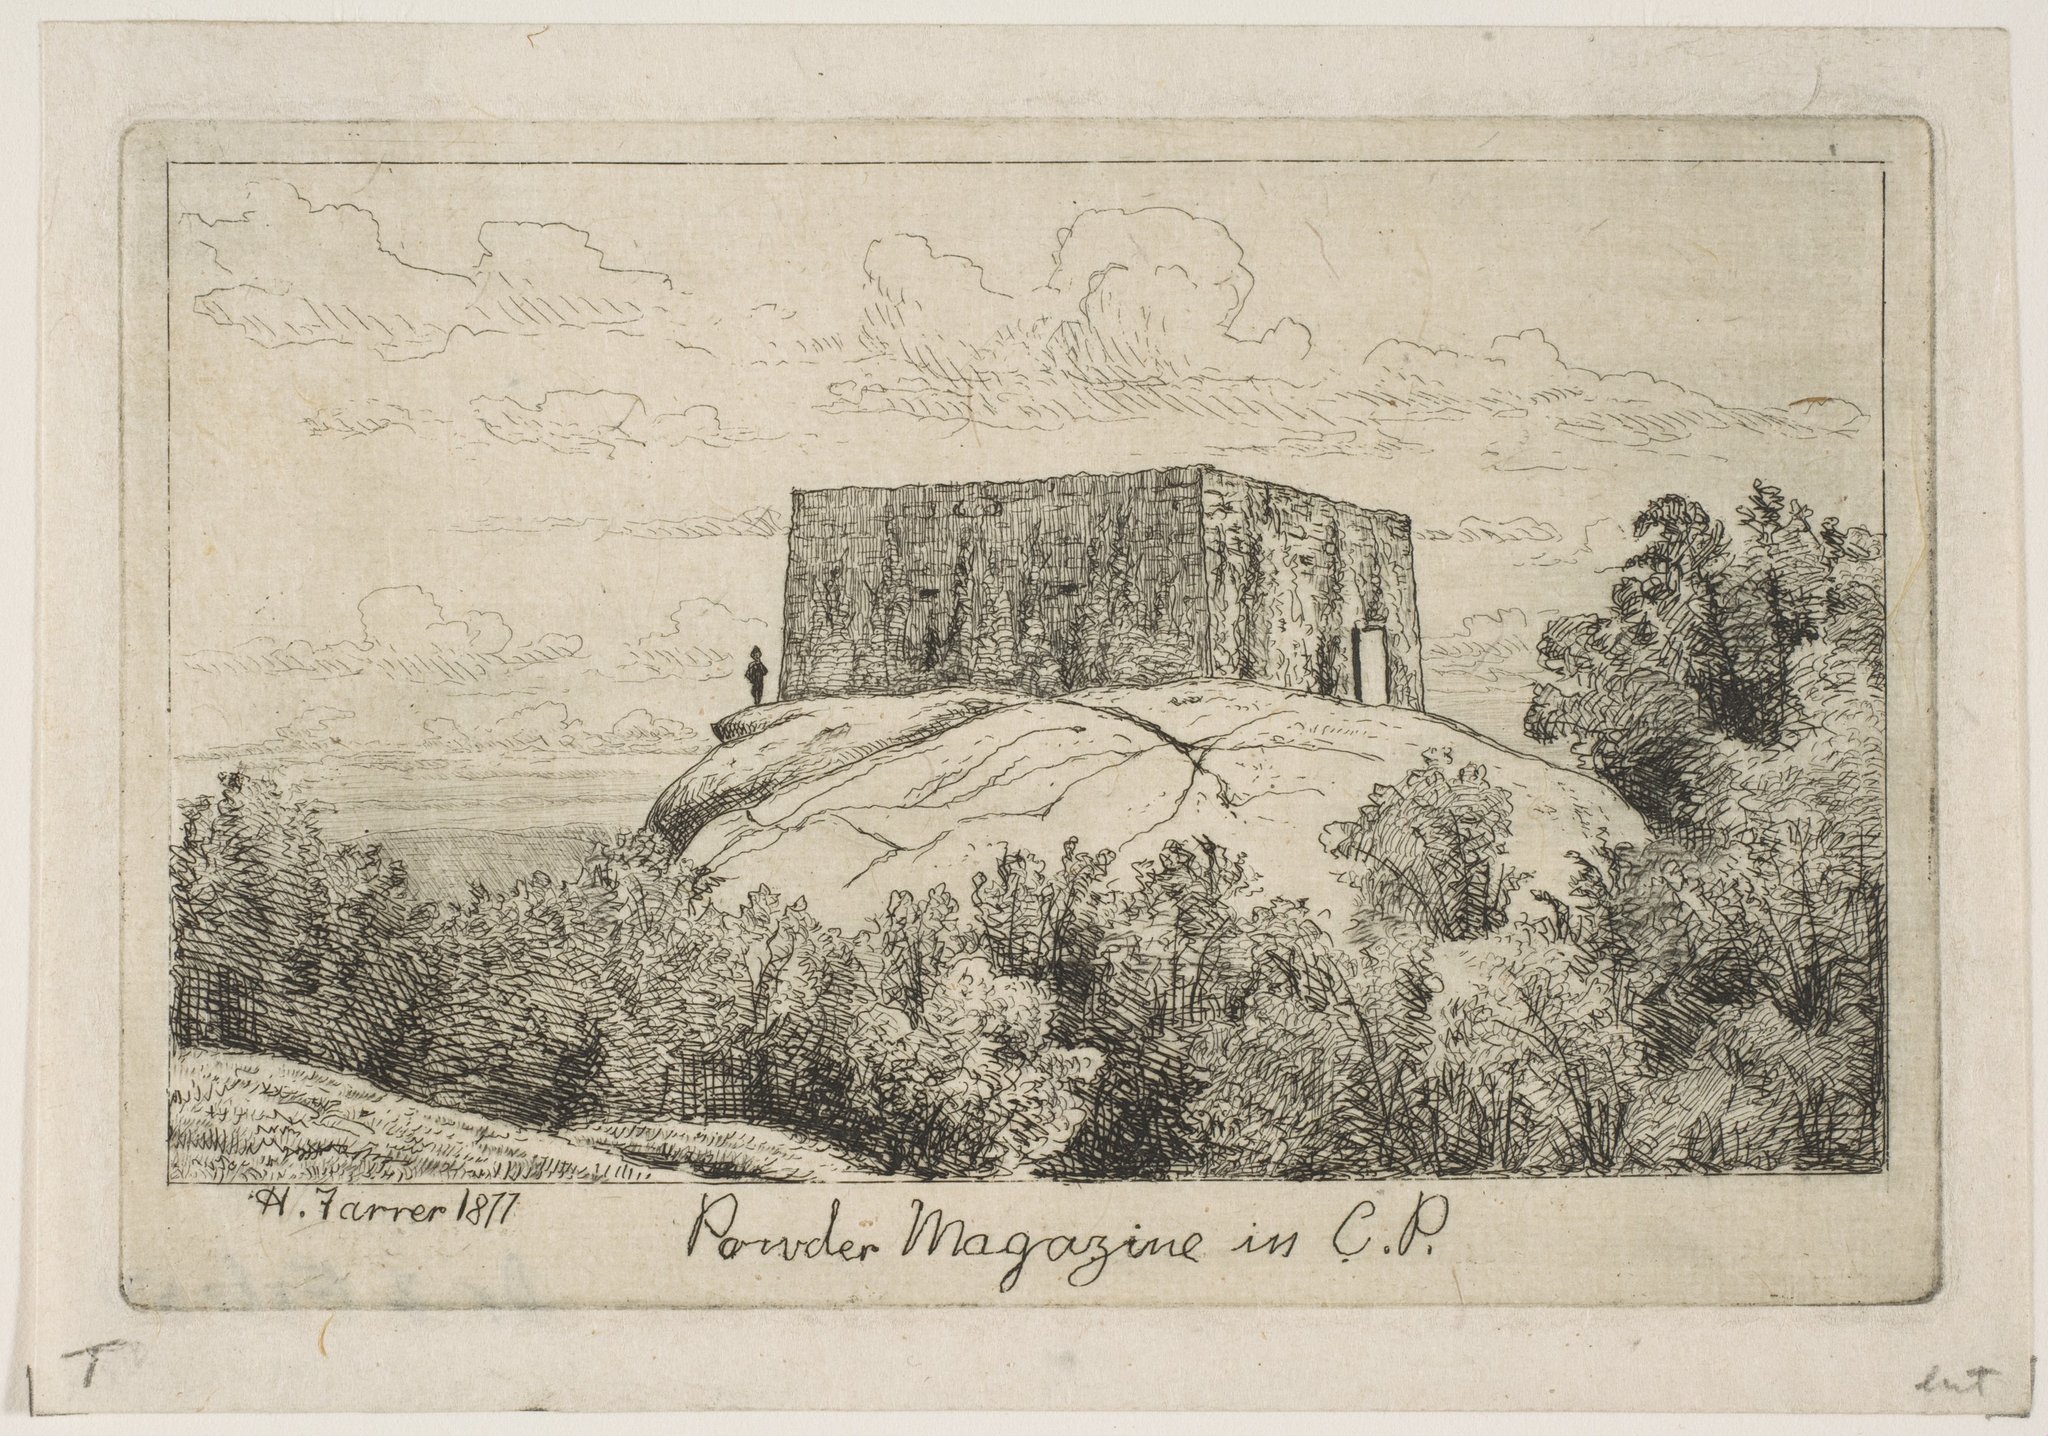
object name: print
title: A Powder Magazine in Central Park, from "Scenes of Old New York"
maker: henry farrer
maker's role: artist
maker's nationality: american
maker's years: 1844-1903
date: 1877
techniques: etching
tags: landscapes,new york city